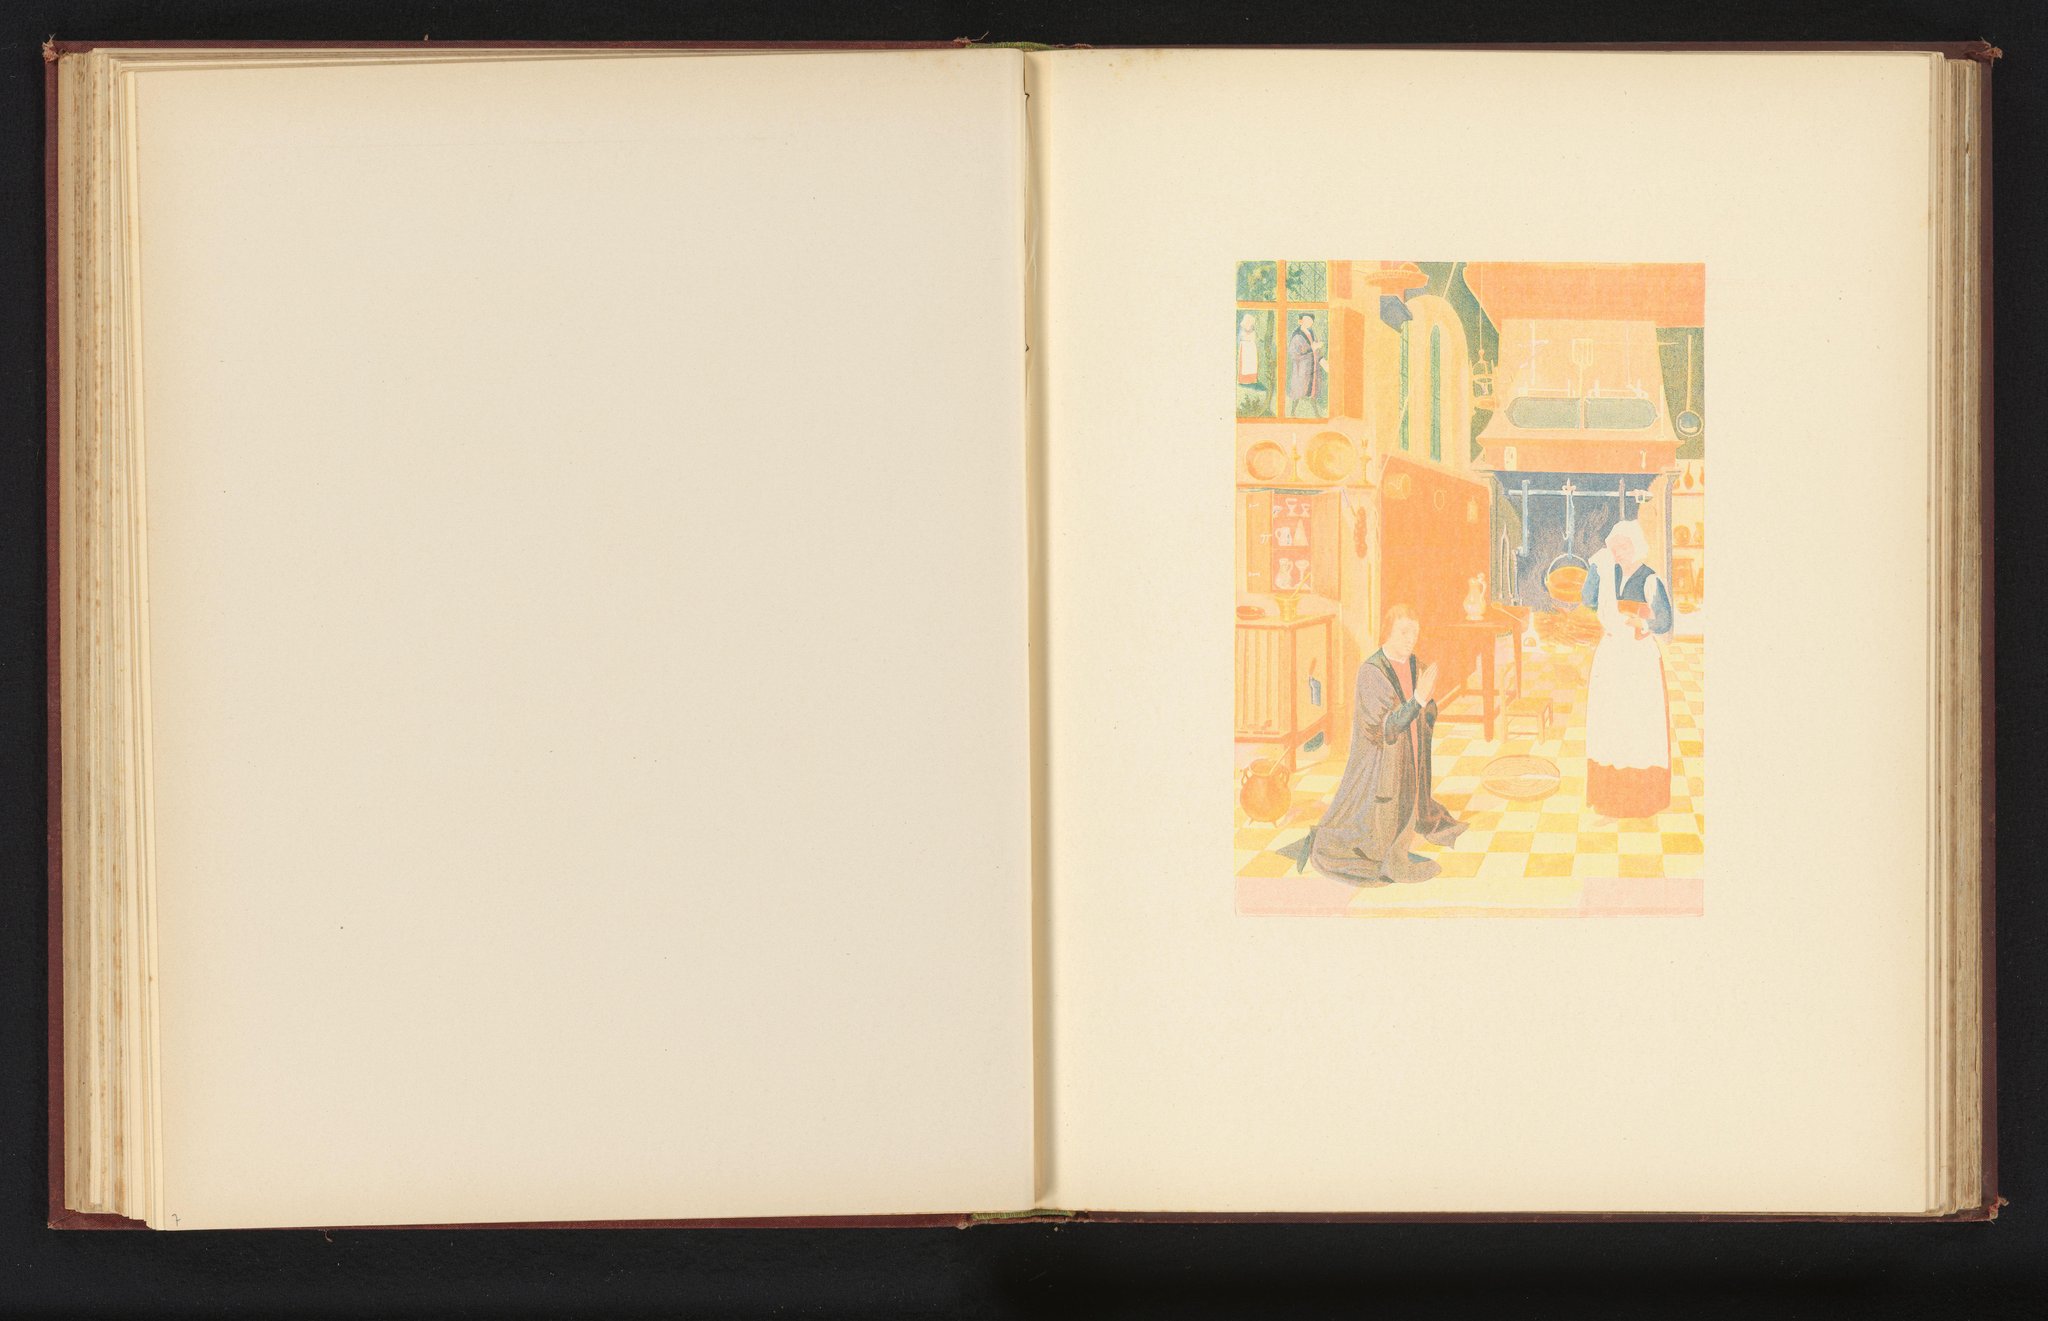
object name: print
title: Reproductie van het schilderij Het mirakel van de gebroken zeef, meerkleurig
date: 1889-1894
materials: paper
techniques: chromolithography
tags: kitchen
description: Prent op elfde ongenummerde pagina na pagina 104.